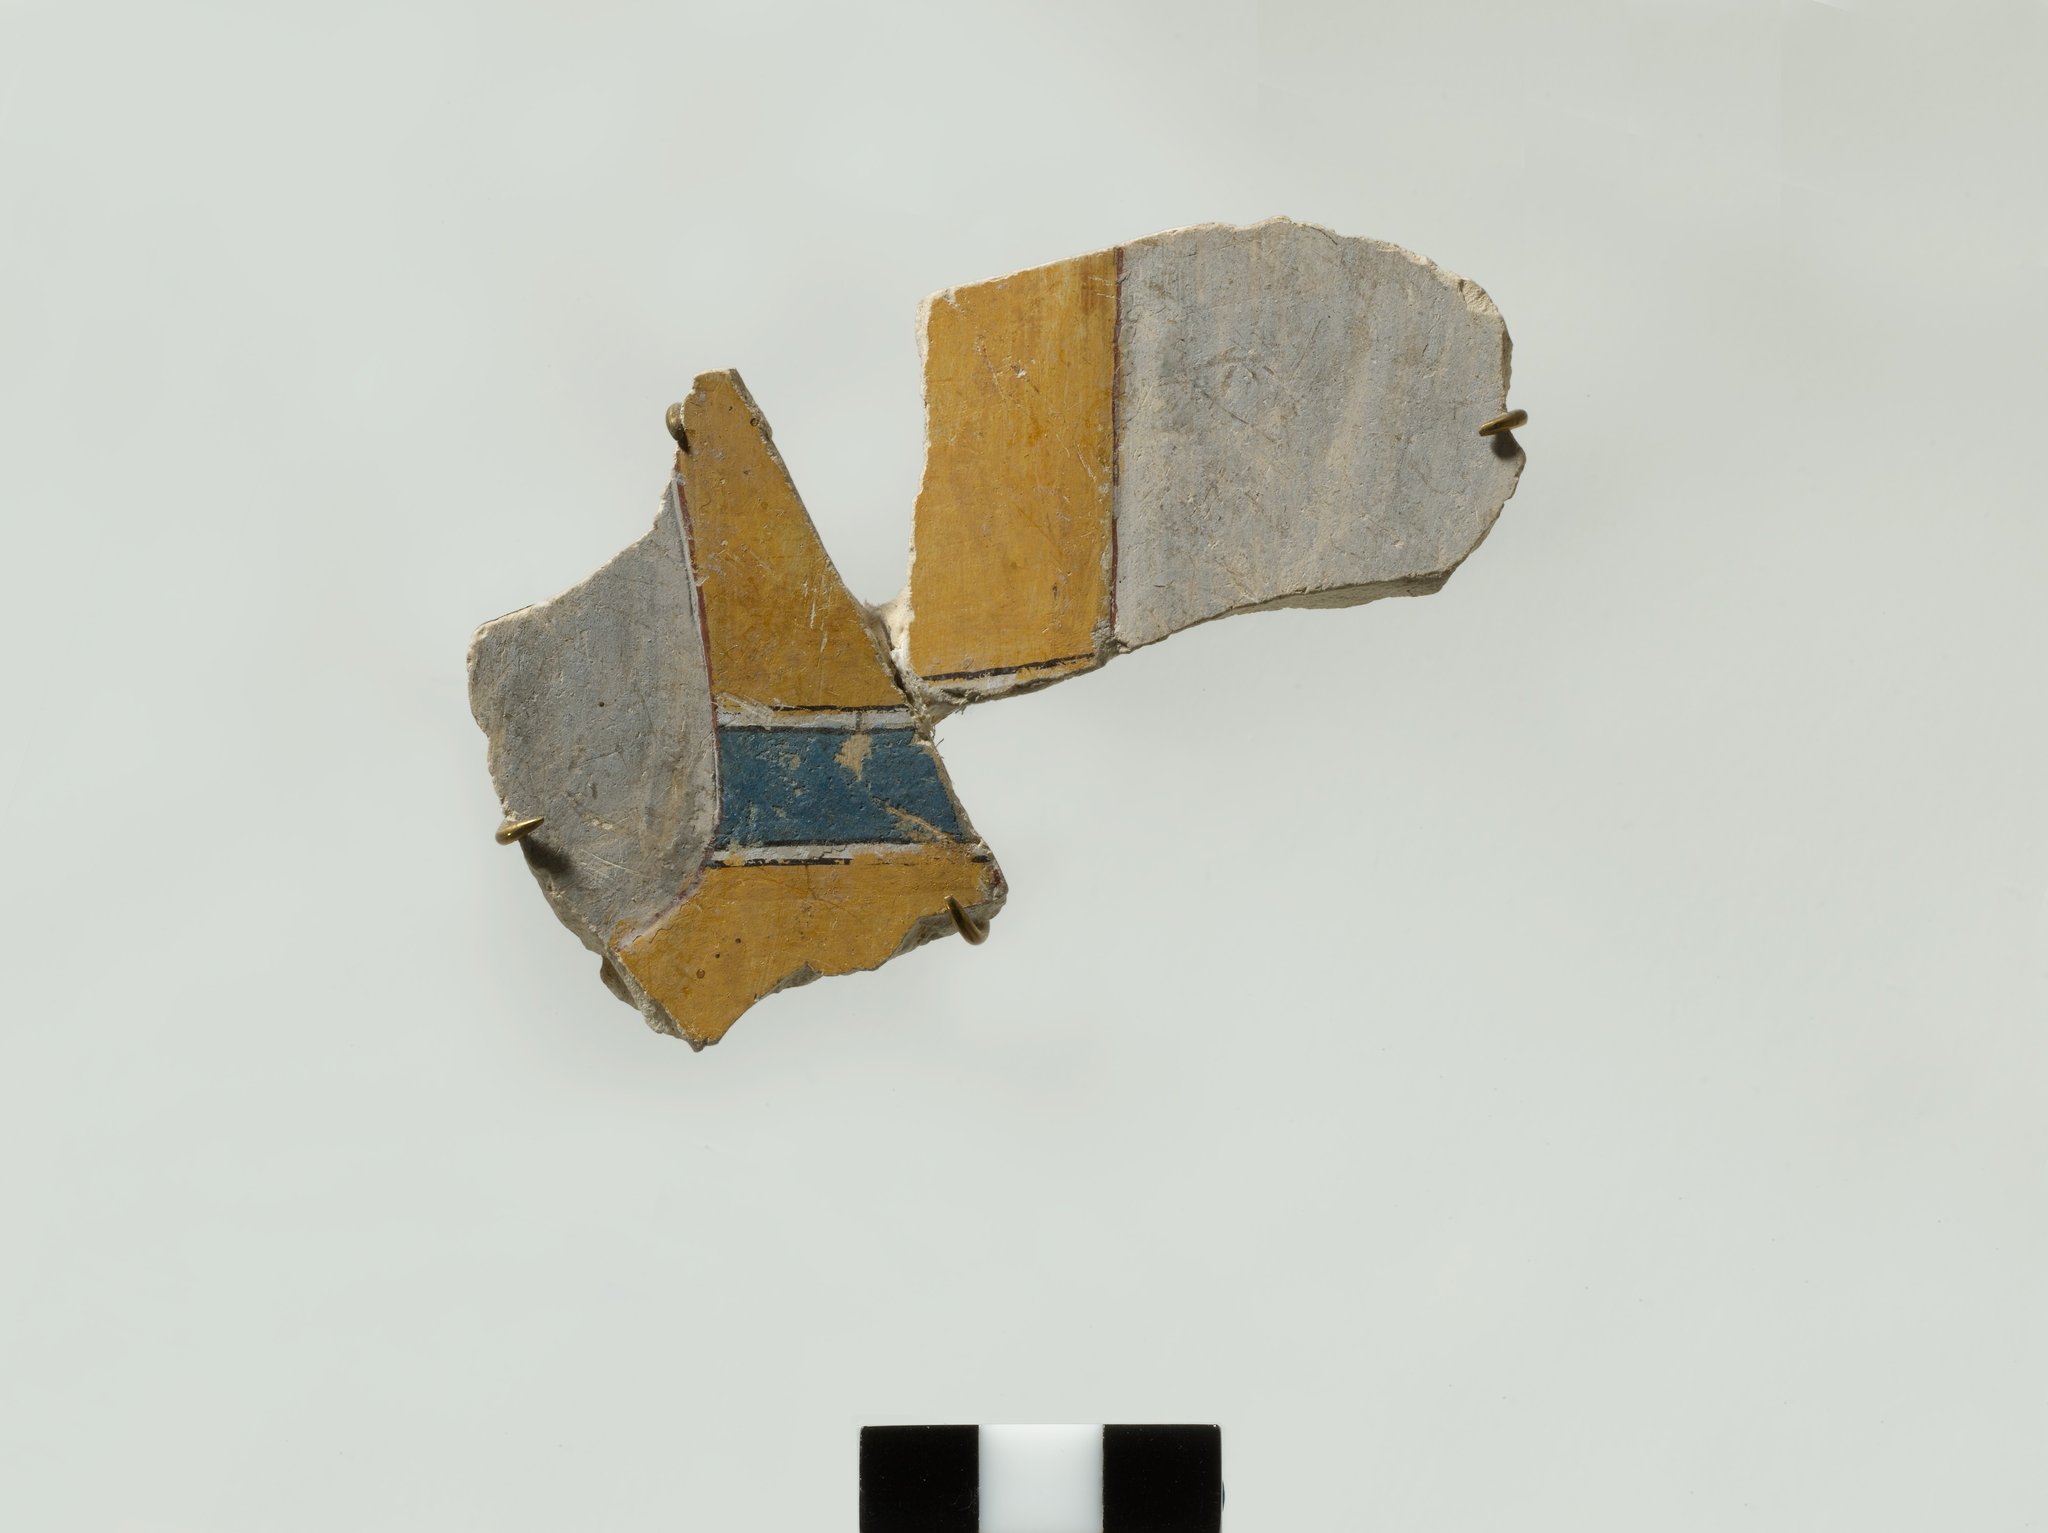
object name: relief fragment, tomb of meketre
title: Relief fragment from the tomb of Meketre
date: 1981-1975 BCE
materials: limestone, paint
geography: egypt